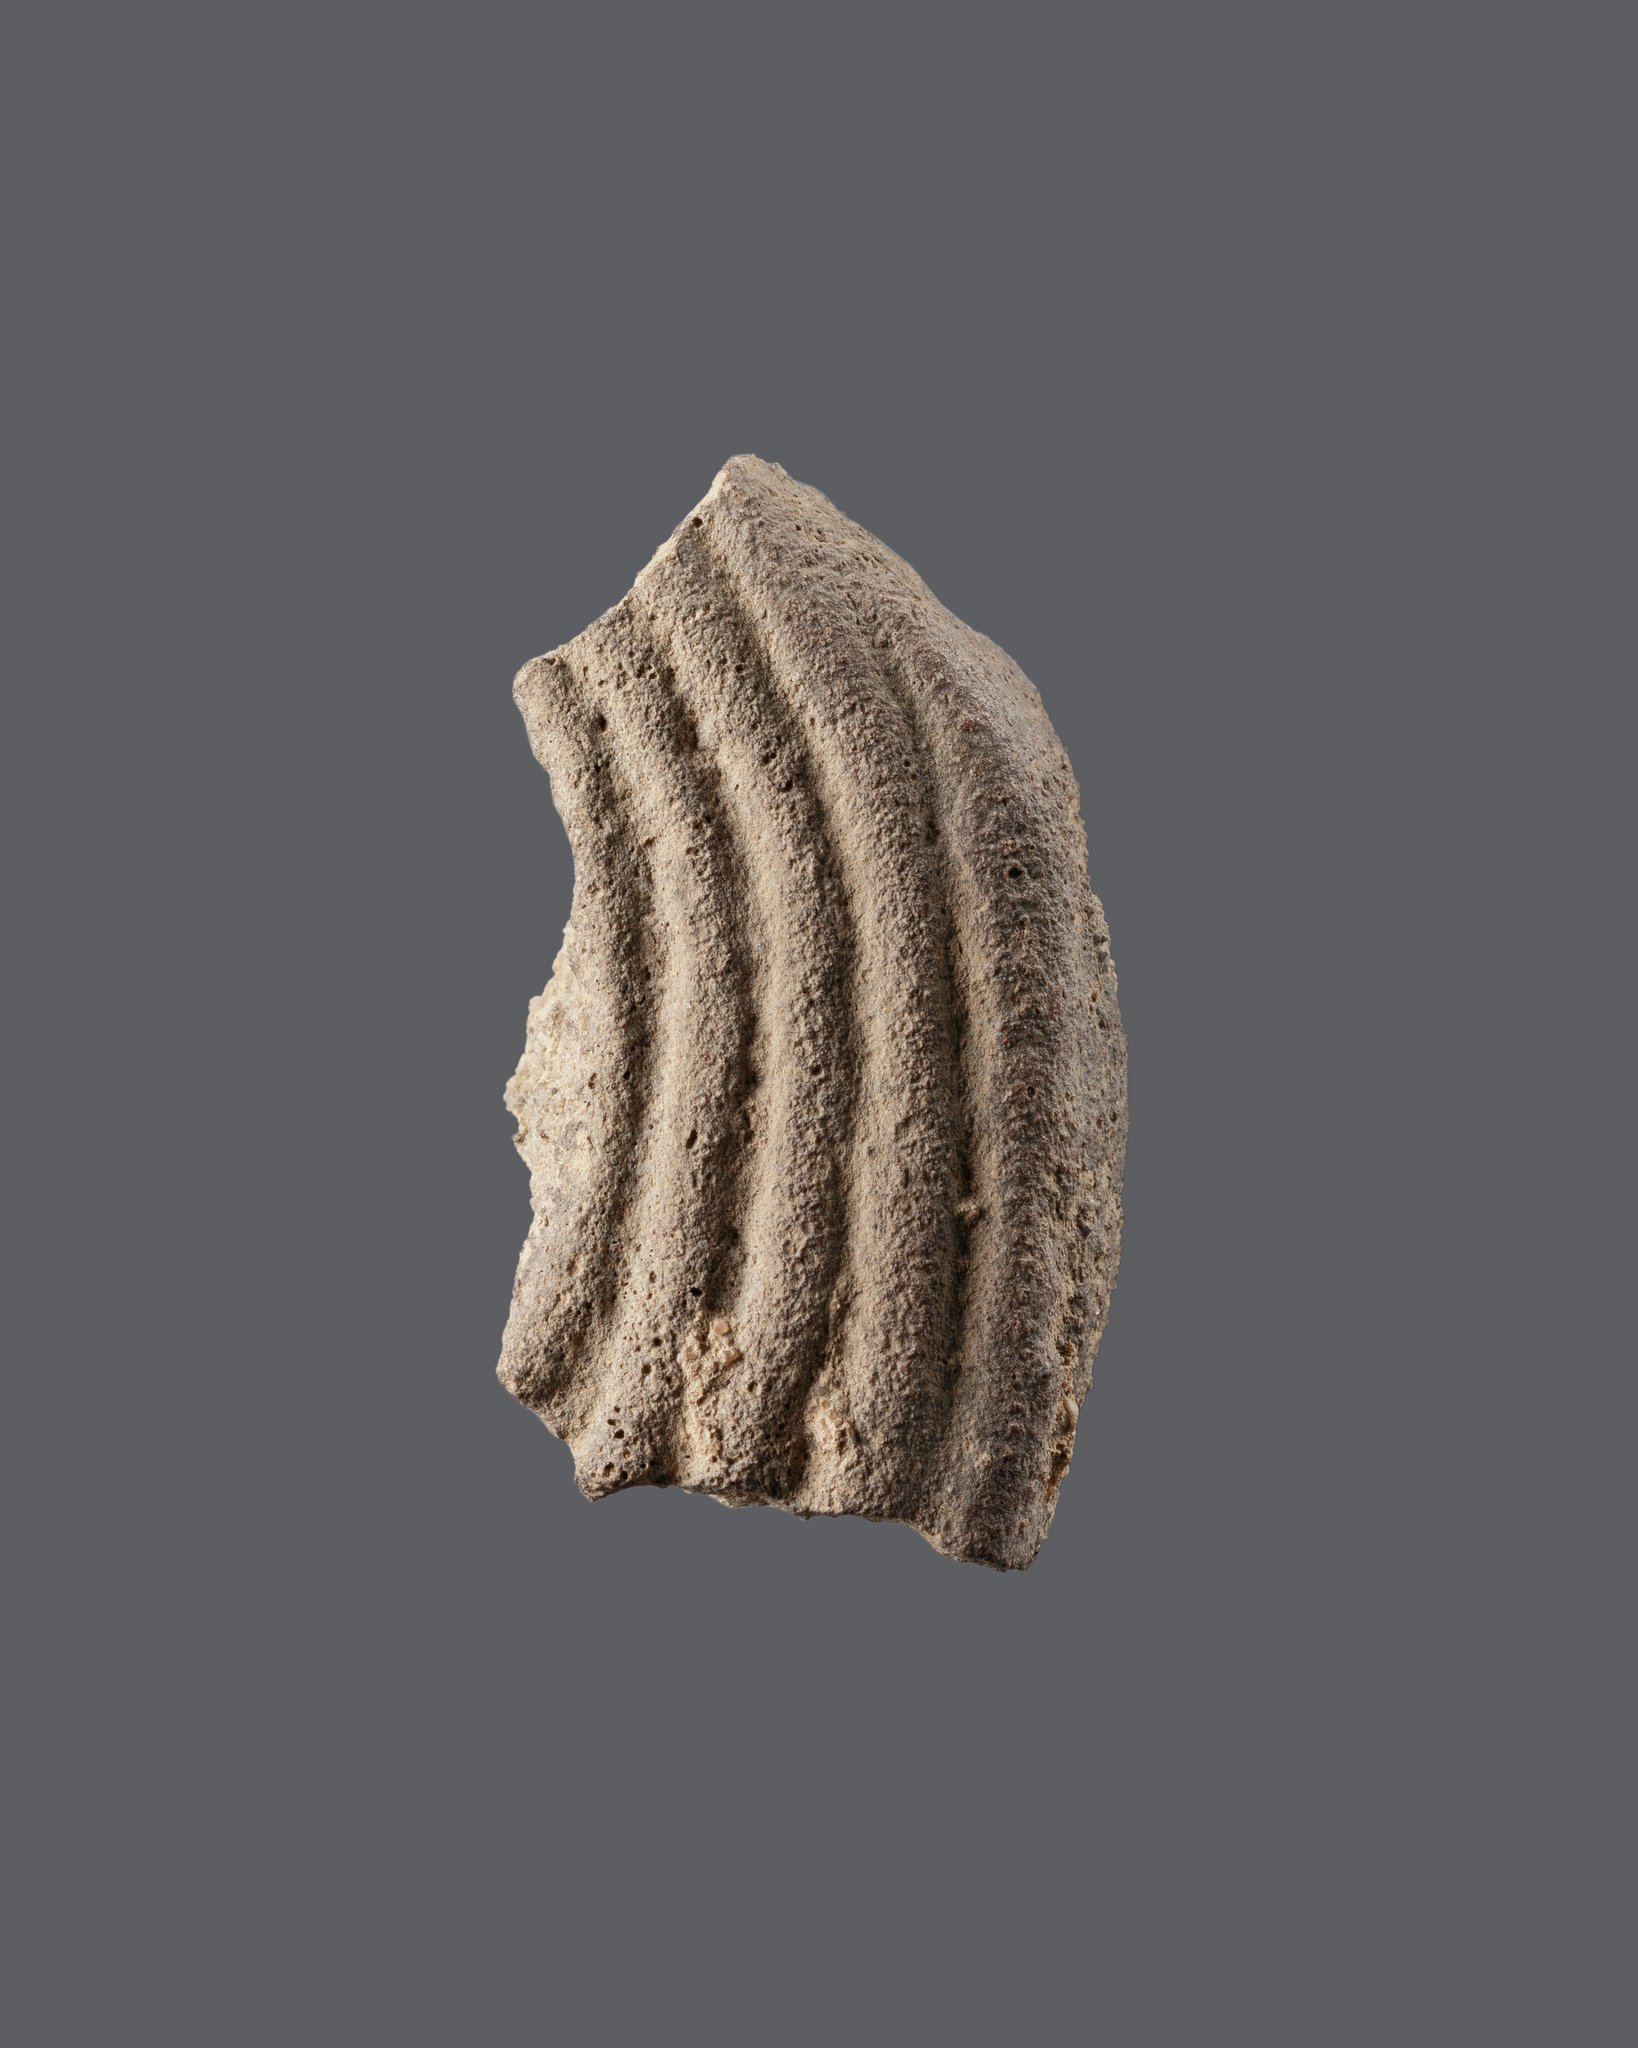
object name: tile, palace of ramesses ii, wig fragment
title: Tile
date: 1279-1213 BCE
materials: faience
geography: egypt